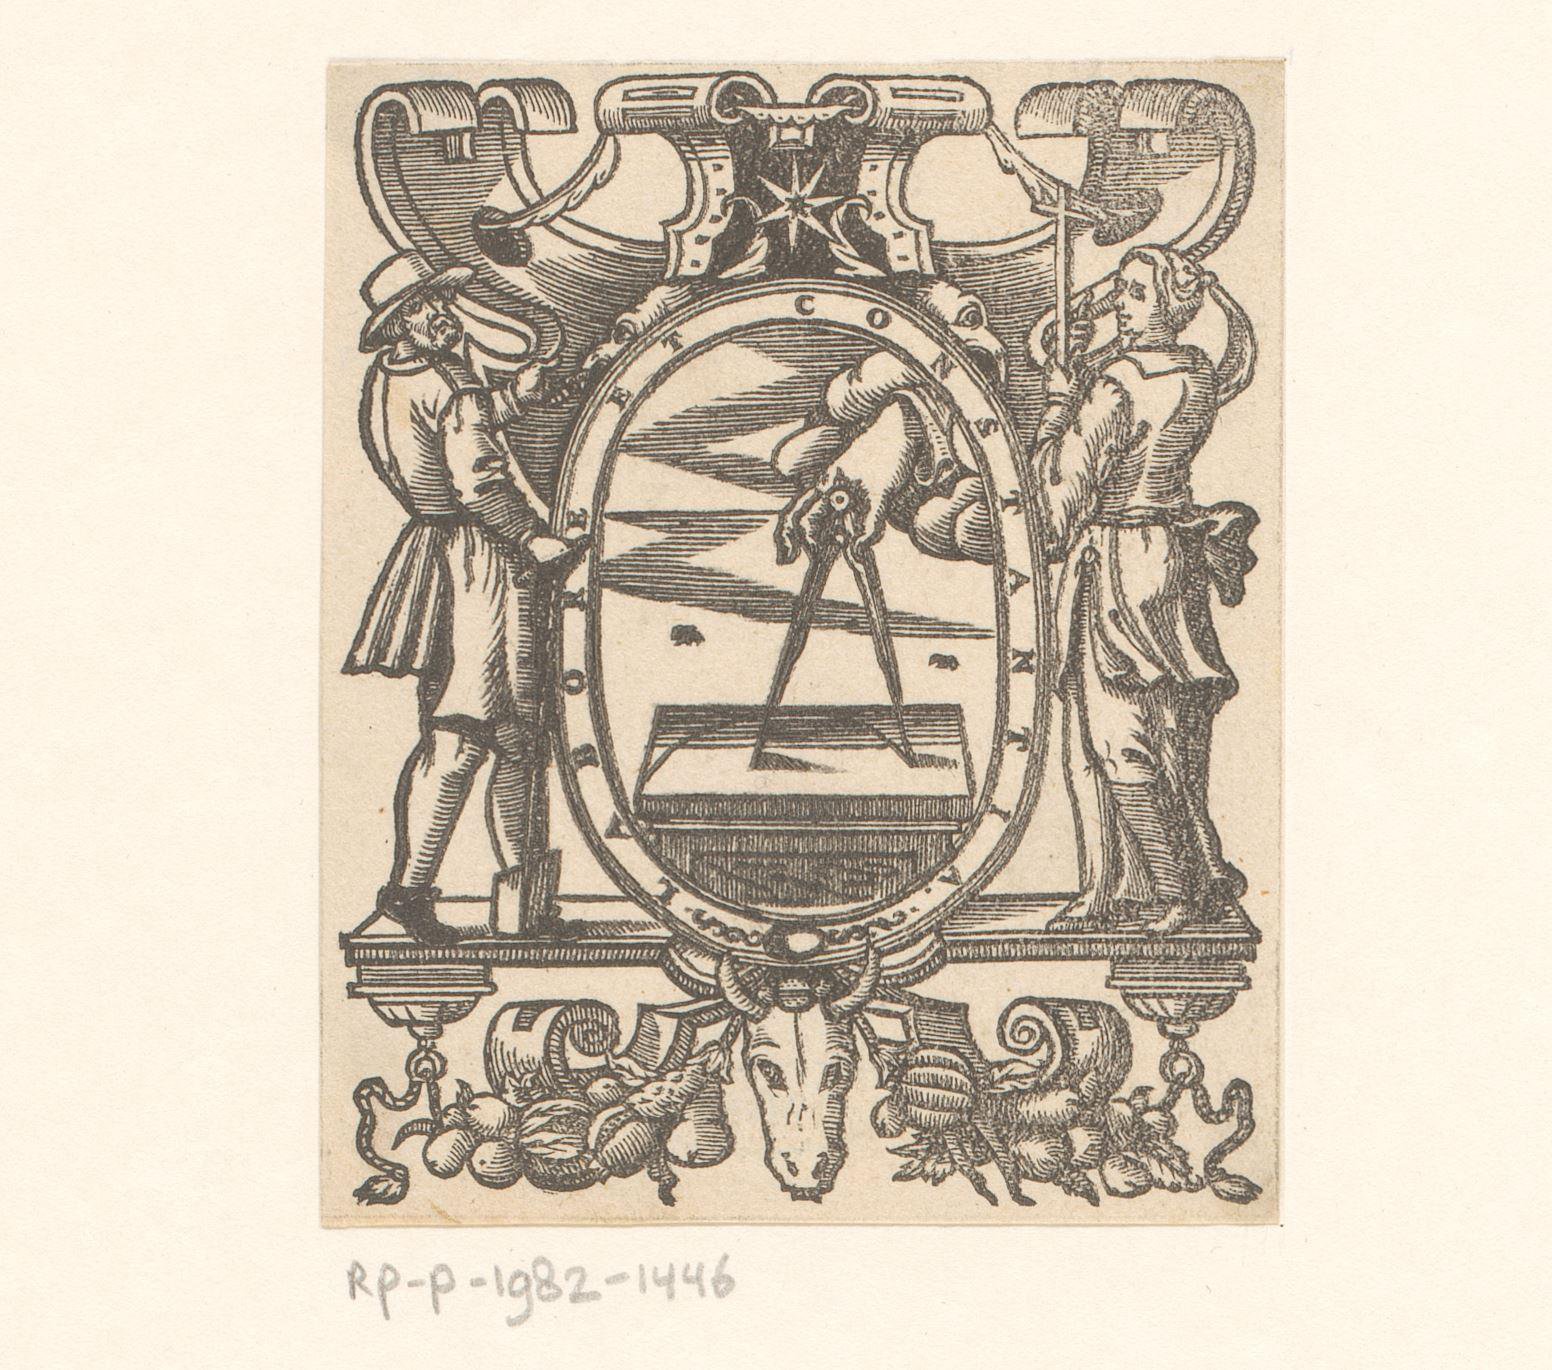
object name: printer's mark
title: Labore et Constantia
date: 1561-1620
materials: paper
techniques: woodcut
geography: antwerp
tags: compasses, device (trade-mark of printer or publisher), constancy, tenacity; 'costanza', 'tenacità' (ripa), abstract ideas and concepts (+ personification)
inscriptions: collector's mark: Lugt 2228, collector's mark: Lugt 2760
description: Drukkersmerk voor de drukkerij Plantijn-Moretus te Antwerpen. In het midden een hand met een passer, een verwijzing naar het uithangbord 'De Gulden Passer'. Rondom de ovale afbeelding het motto: Labore et Constantia. Hiernaast de personificaties van Labore en Constantia, met schep en crucifix.